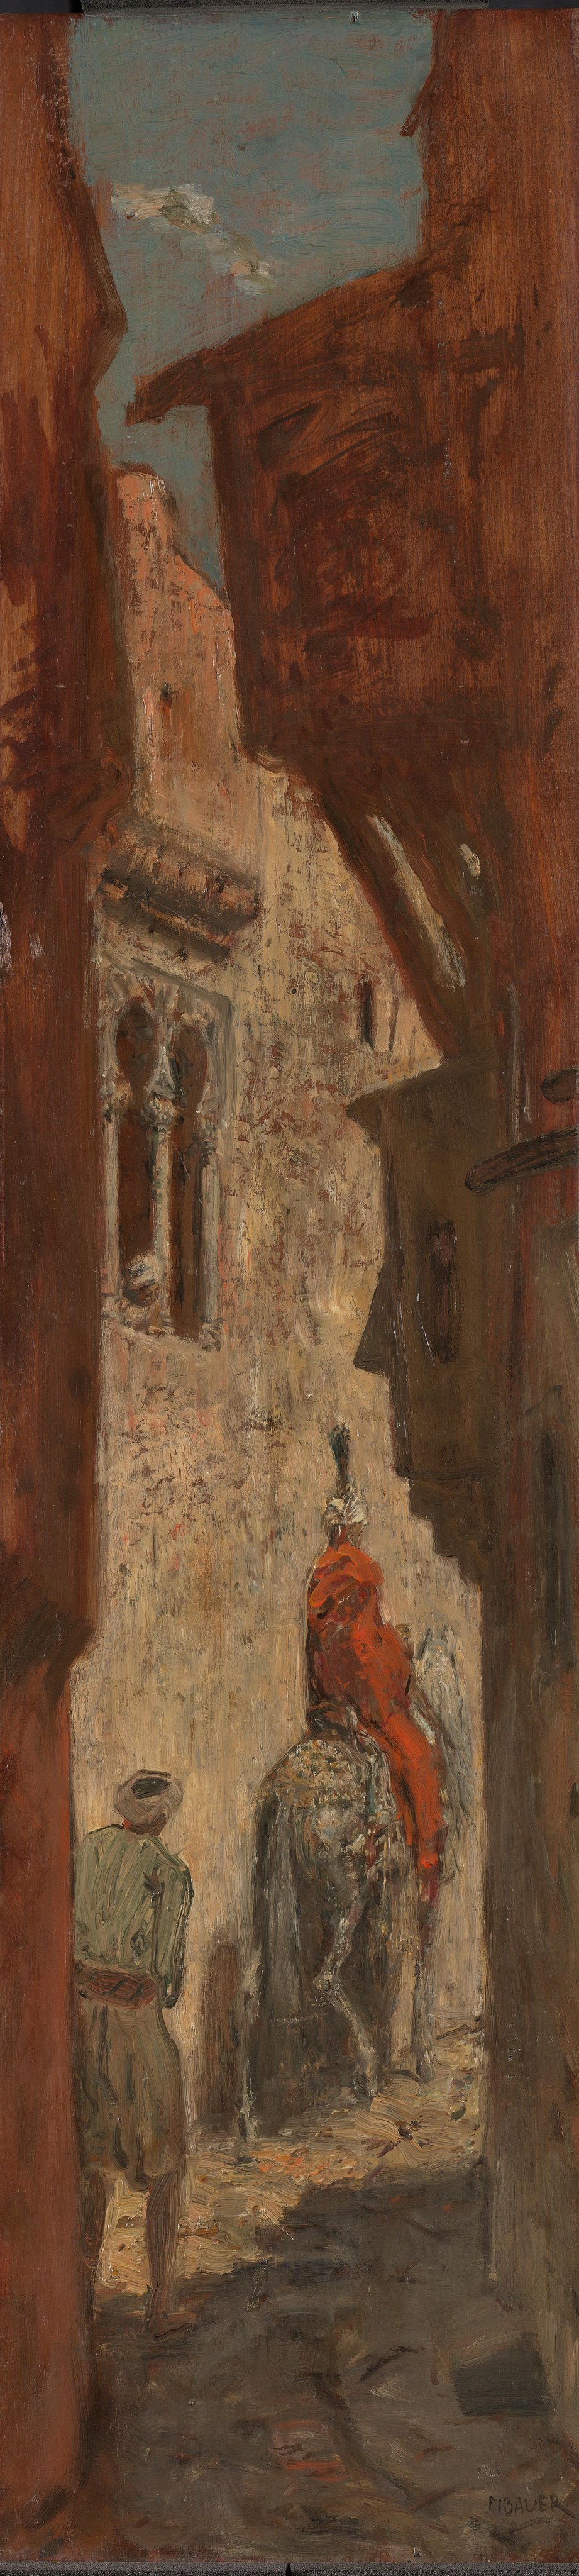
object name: painting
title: Orental Street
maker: marius bauer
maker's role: draughtsman, print maker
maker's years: 1867-1932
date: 1911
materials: oil, panel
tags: street (+ city(-scape) with figures, staffage)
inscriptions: signature: ‘M. Bauer’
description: Gezicht in een Oosterse straat met een ruiter. Gemaakt voor in de hal van het Londense huis van Sir Lawrence Alma Tadema.